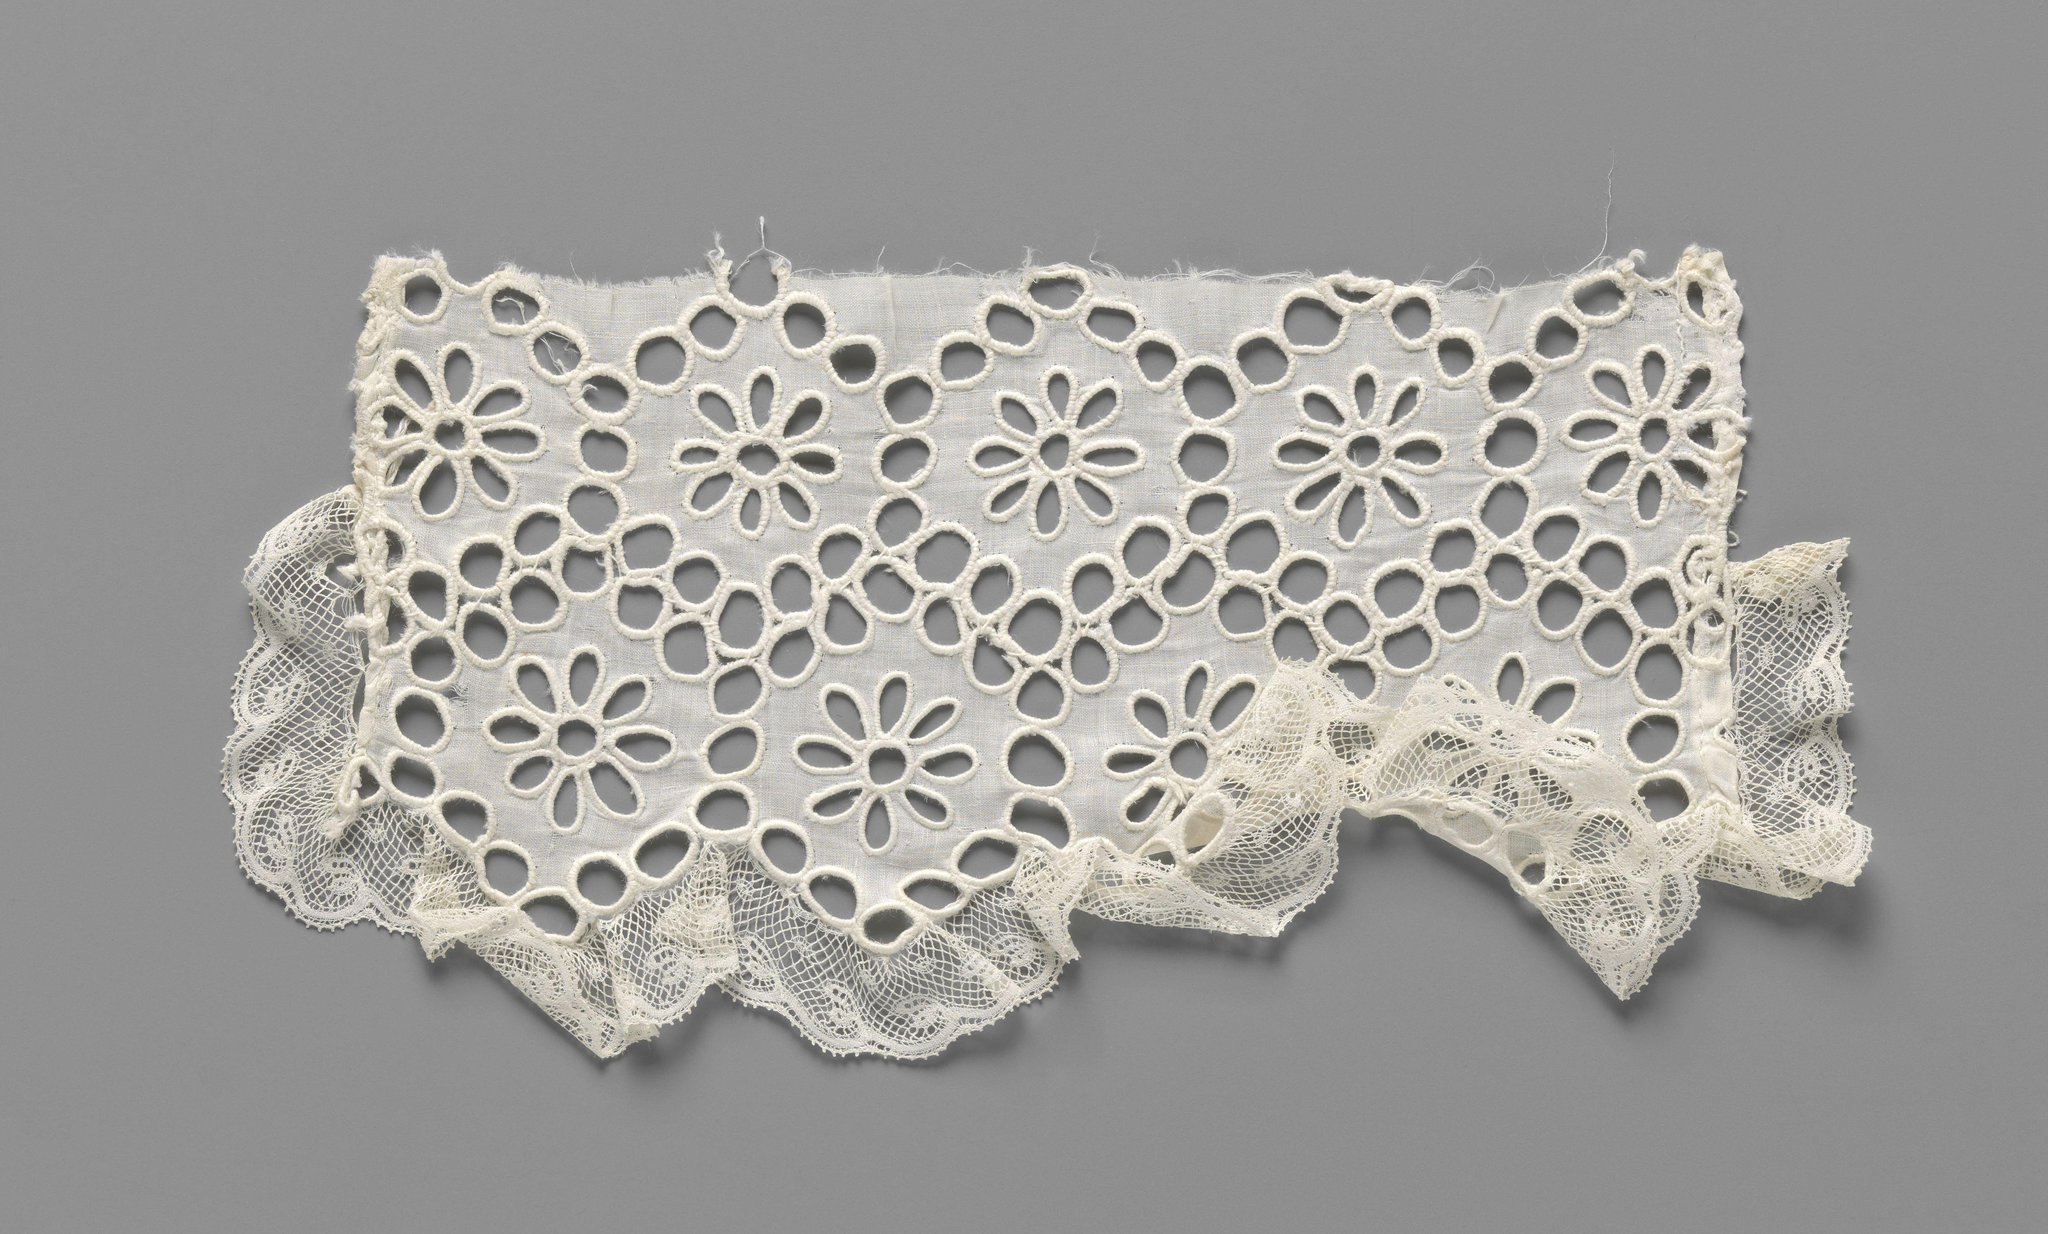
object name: cuff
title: Manchet van batist met aaneengesloten zeshoeken waarin margrieten van kantborduurwerk en aan drie zijden afgewerkt met een strookje machinale kant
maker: c.i. bosch reitz-teding van berkhout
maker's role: kantwerkster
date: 1870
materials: textile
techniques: lace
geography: amsterdam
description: Manchet van naturelkleurig batist met kantborduurwerk: Engels borduurwerk. Rechthoekig model met schulpenrand aan de onderzijde. Het patroon bestaat uit een rij aaneengesloten zeshoeken gemaakt met opengewerkte cirkeltjes, met in elke zeshoek een opengewerkte margriet. De schulpenrand volgt het patroon met de zeshoeken. De manchet is langs drie zijden afgewerkt met een gerimpeld aangezet strookje machinale kant: machinale Valenciennes-kant. Het borduurwerk is gemaakt rond 1870, de kraag rond 1910.